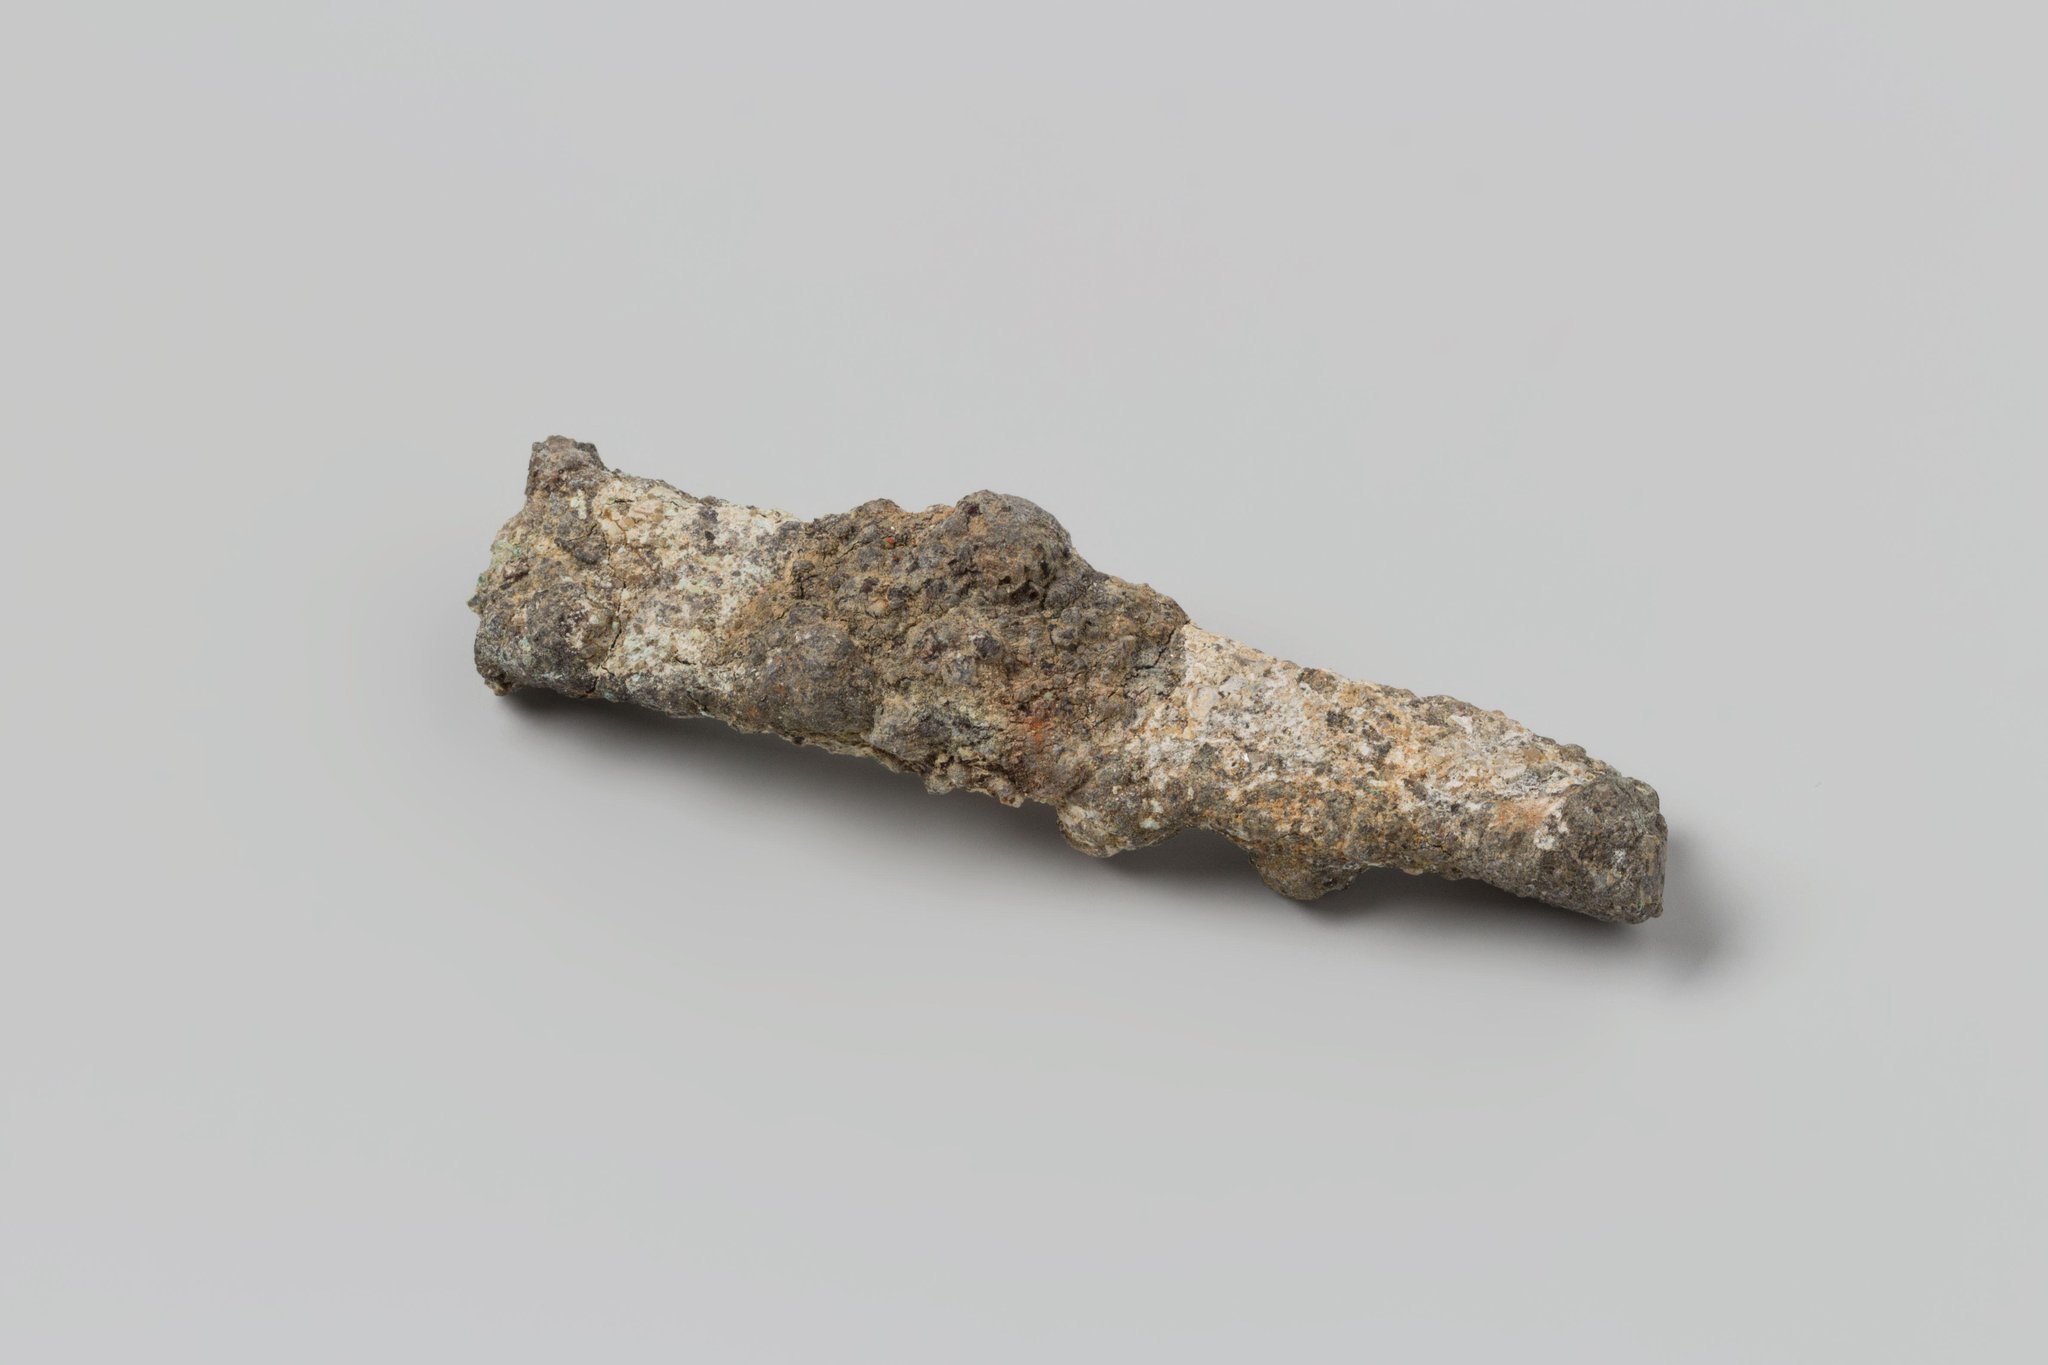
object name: fork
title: Fragment steel van vork of lepel uit het wrak van de Oost-Indiëvaarder Hollandia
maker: Anonymous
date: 1700-1743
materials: tin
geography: netherlands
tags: verenigde oostindische compagnie, hollandia (schip), annet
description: Cutlery, fragment: stem of fork or spoon; fragm, heavily corroded, semicircular in section.